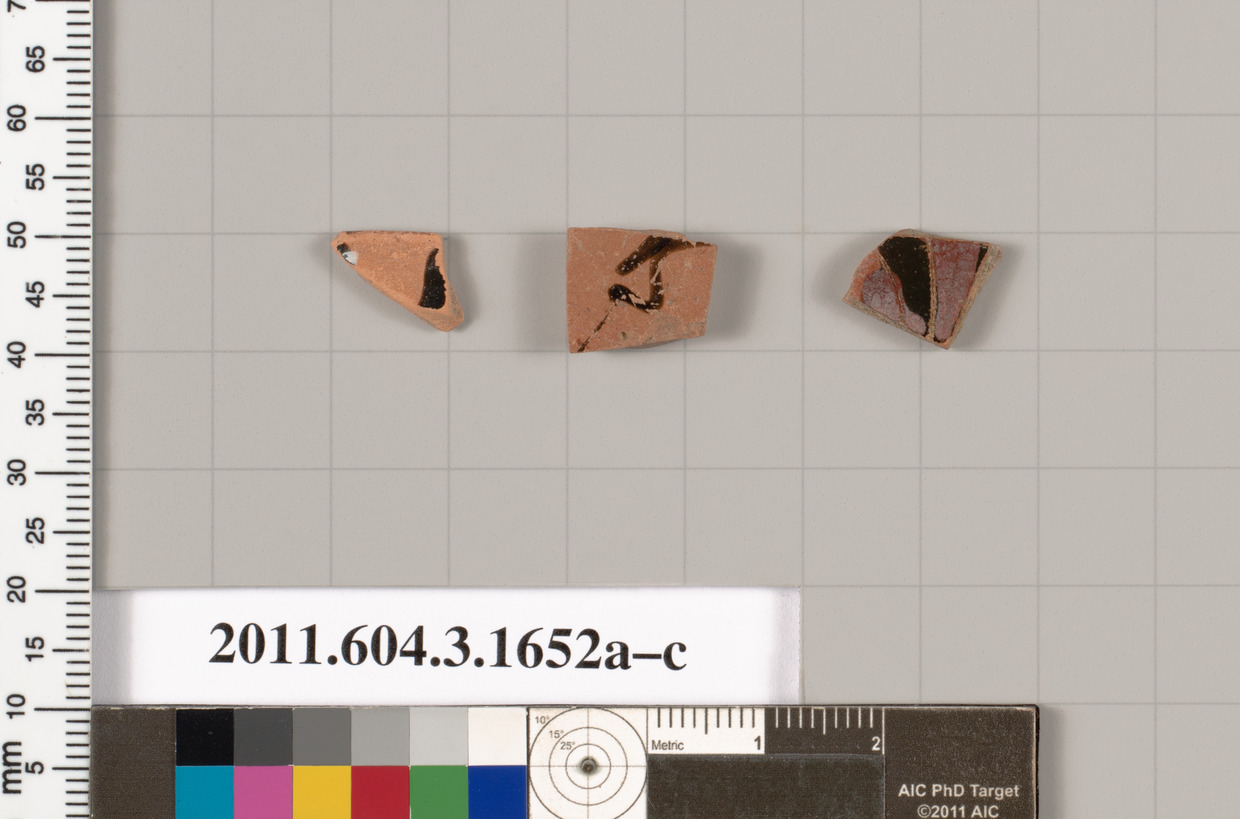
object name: kylix fragment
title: Terracotta fragments of kylikes: Band or lip cups (drinking cups)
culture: greek, attic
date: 550-526 BCE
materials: terracotta